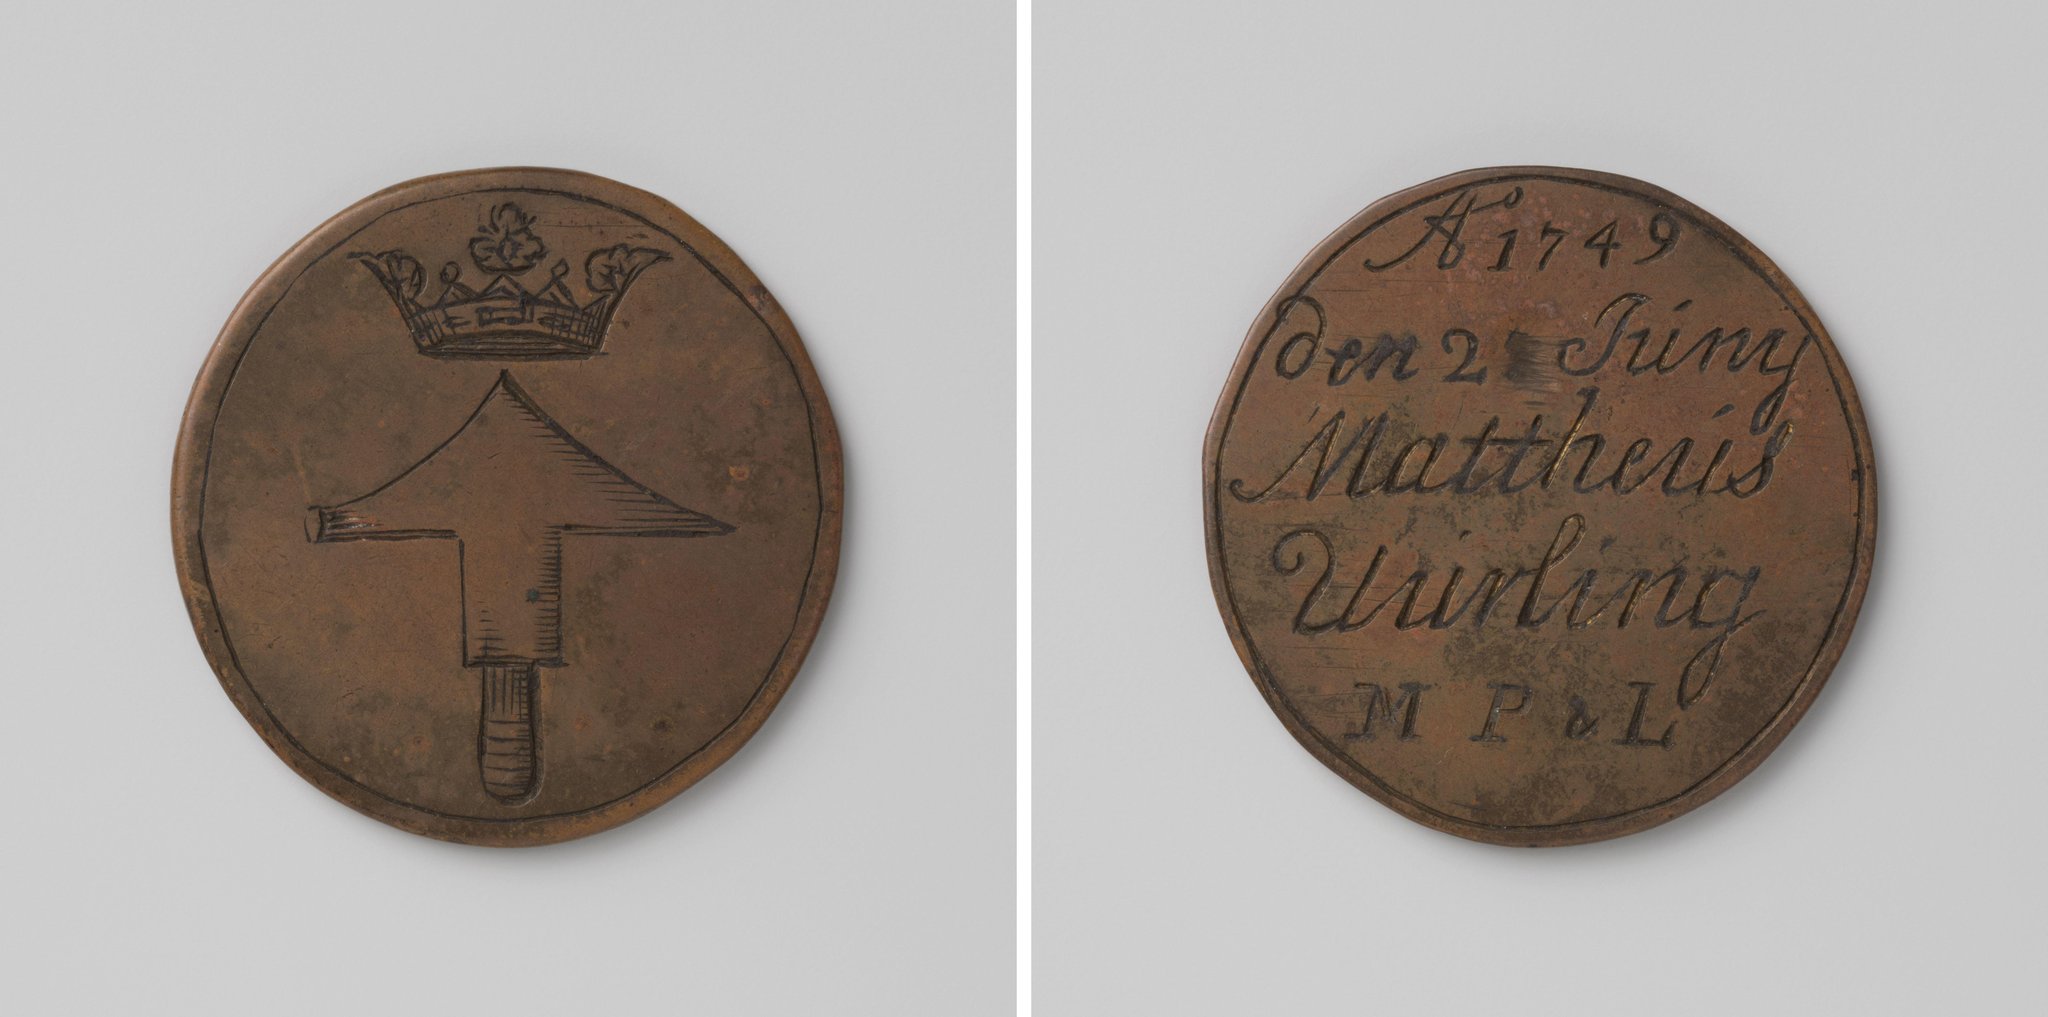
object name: medal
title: Metselaars-, steenhouwers-, leidekkers-, loodgieters- en pompenmakersgilde van Amsterdam, gildepenning van Mattheus Uurling, metselaar, pompmaker en loodgieter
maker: Anonymous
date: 1749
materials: copper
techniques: engraving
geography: amsterdam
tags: amsterdam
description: Koperen penning. Voorzijde: gekroonde loodgietershamer. Keerzijde: opschrift